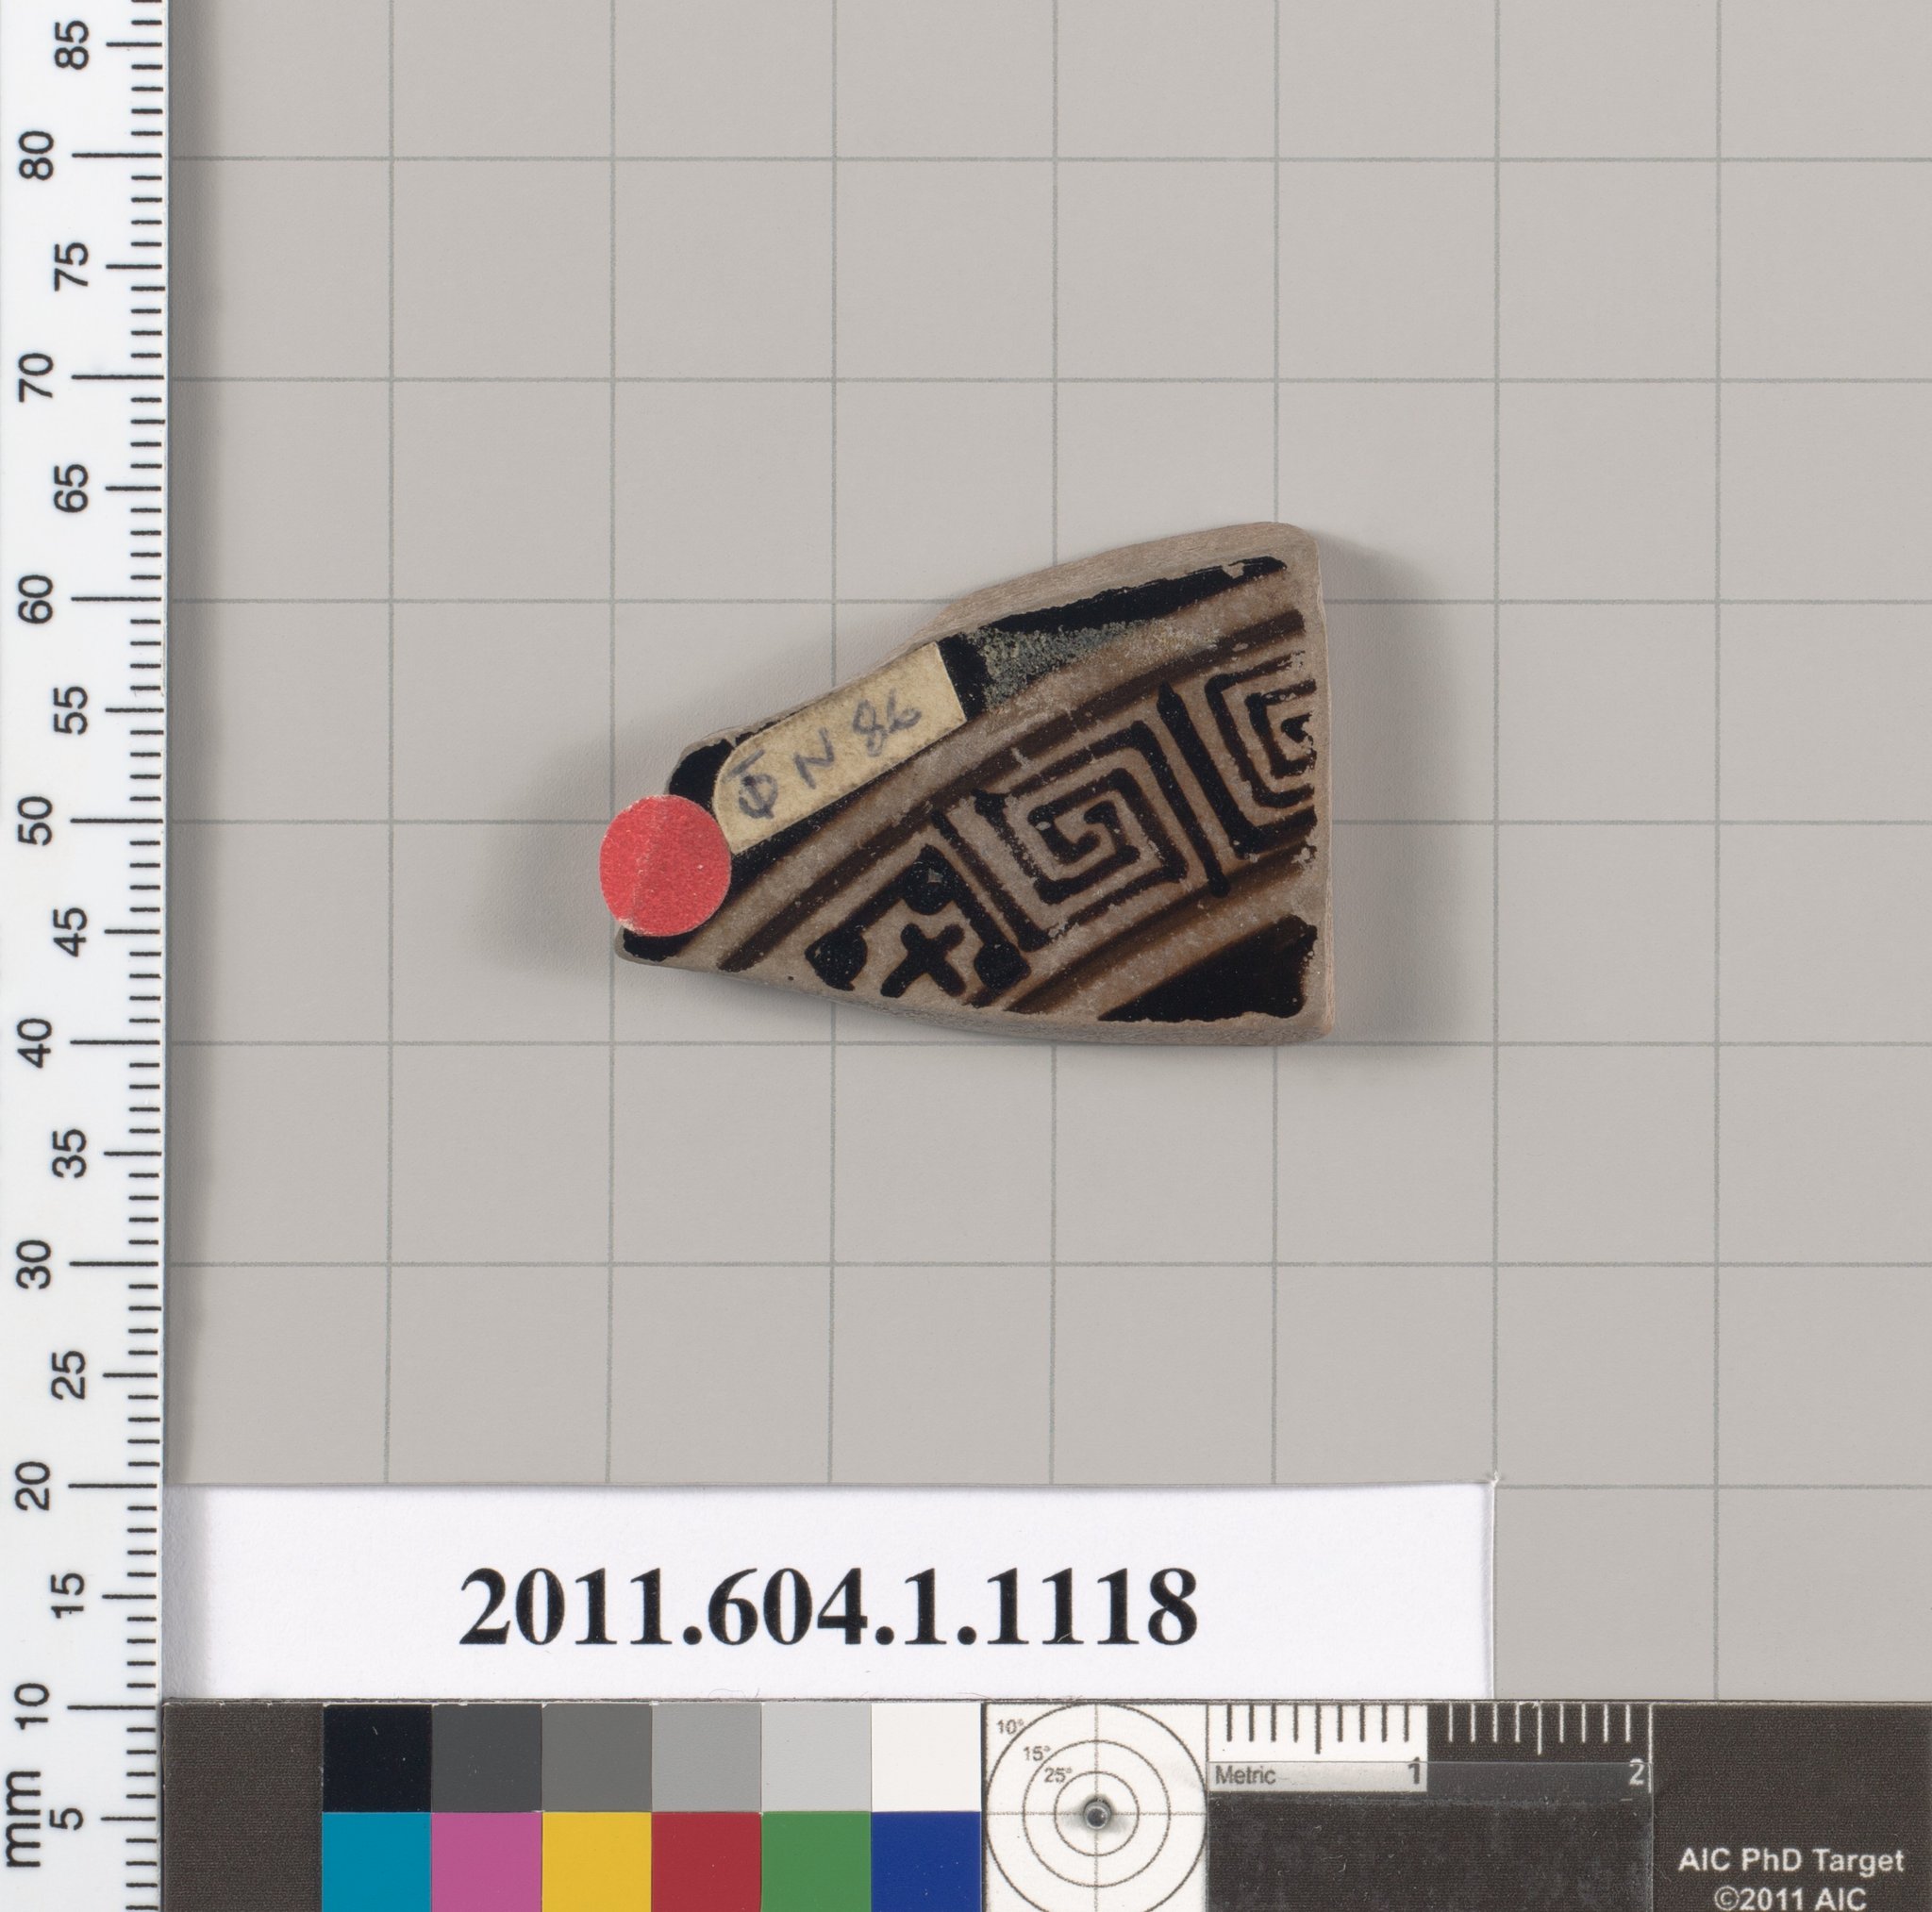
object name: kylix fragment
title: Terracotta fragment of a kylix (drinking cup)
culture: greek, attic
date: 490-480 BCE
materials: terracotta